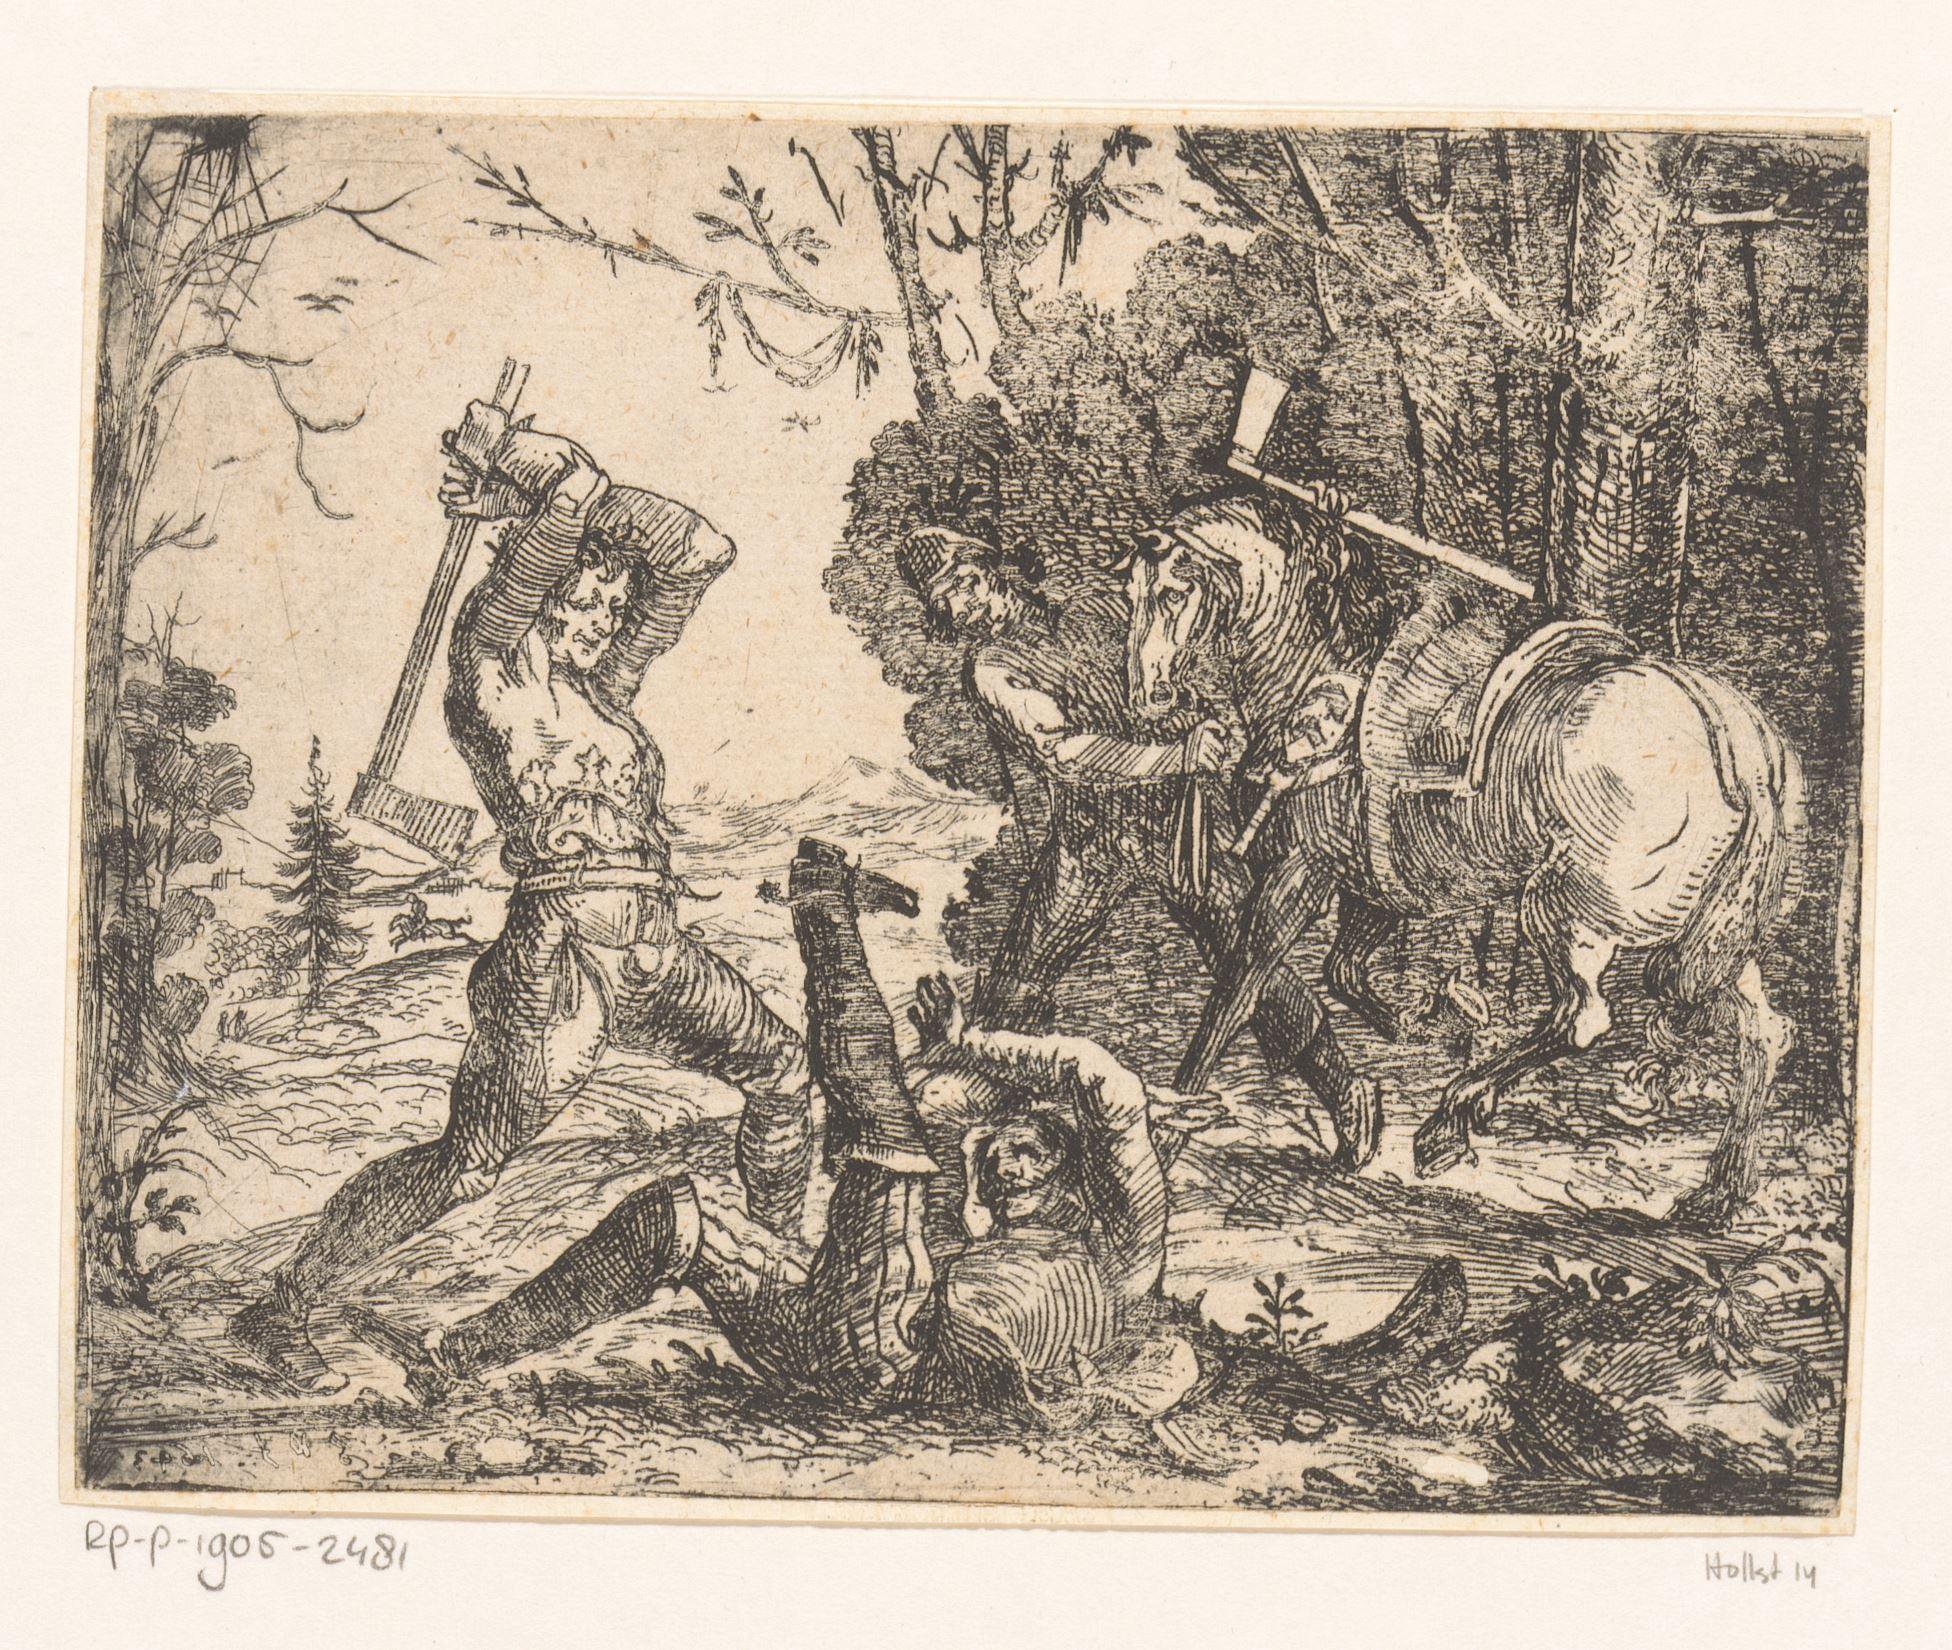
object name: print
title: Twee rovers vallen een ruiter aan met bijlen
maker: hans ulrich franck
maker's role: draughtsman, print maker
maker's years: 1603-1680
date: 1643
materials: paper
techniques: etching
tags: traveller(s) attacked by robber(s), tools, aids, implements ~ crafts and industries: axe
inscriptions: collector's mark: ‘kunstverein’, collector's mark: Lugt 2228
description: Prent uit een serie van vijfentwintig militaire voorstellingen, waarvan tien in de collectie van het RMA aanwezig zijn.